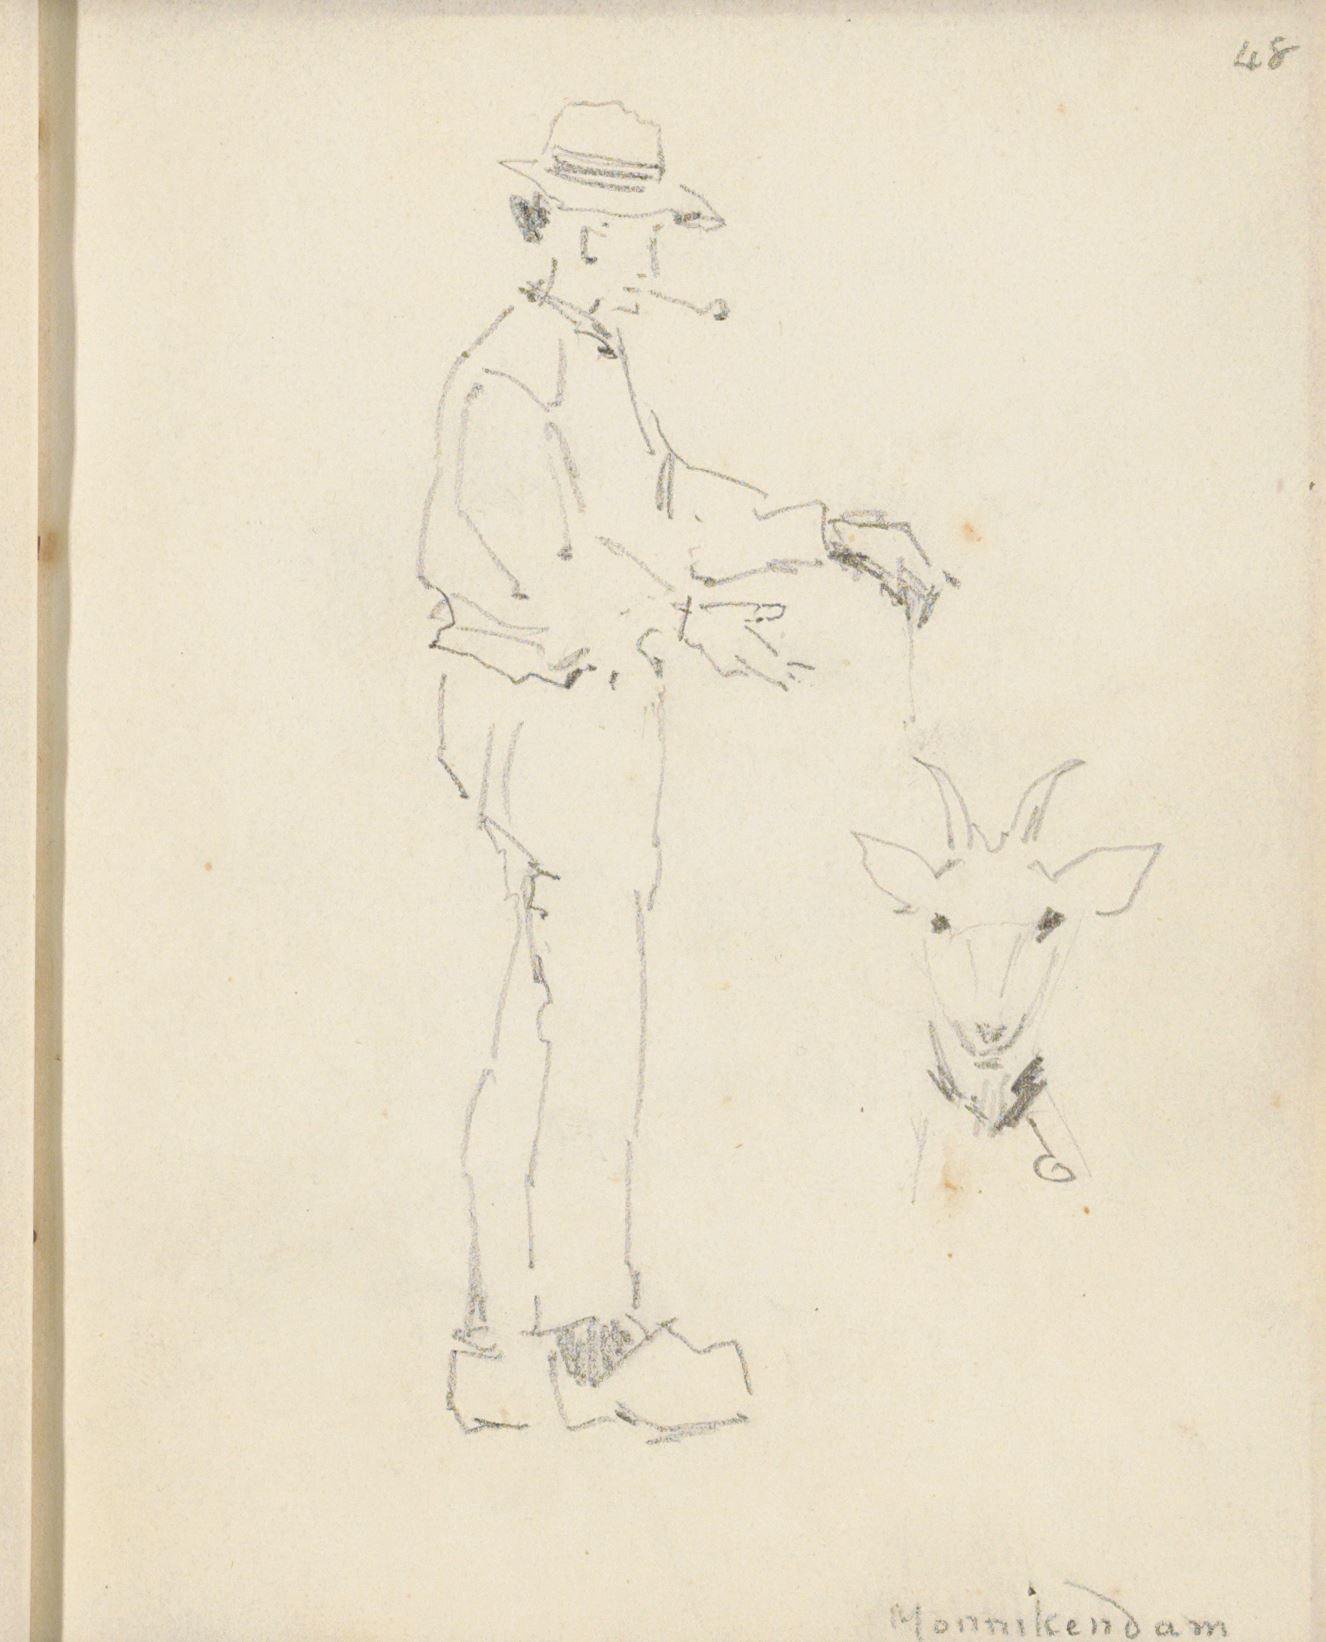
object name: sketchbook leaf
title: Man uit Monnickendam en een geit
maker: alfred william rich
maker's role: draughtsman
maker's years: 1856-1921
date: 1892-1893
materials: paper, pencil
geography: monnickendam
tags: standing figure, goat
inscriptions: annotation: ‘Monnikendam’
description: Blad 48 recto uit een schetsboek met 86 bladen.